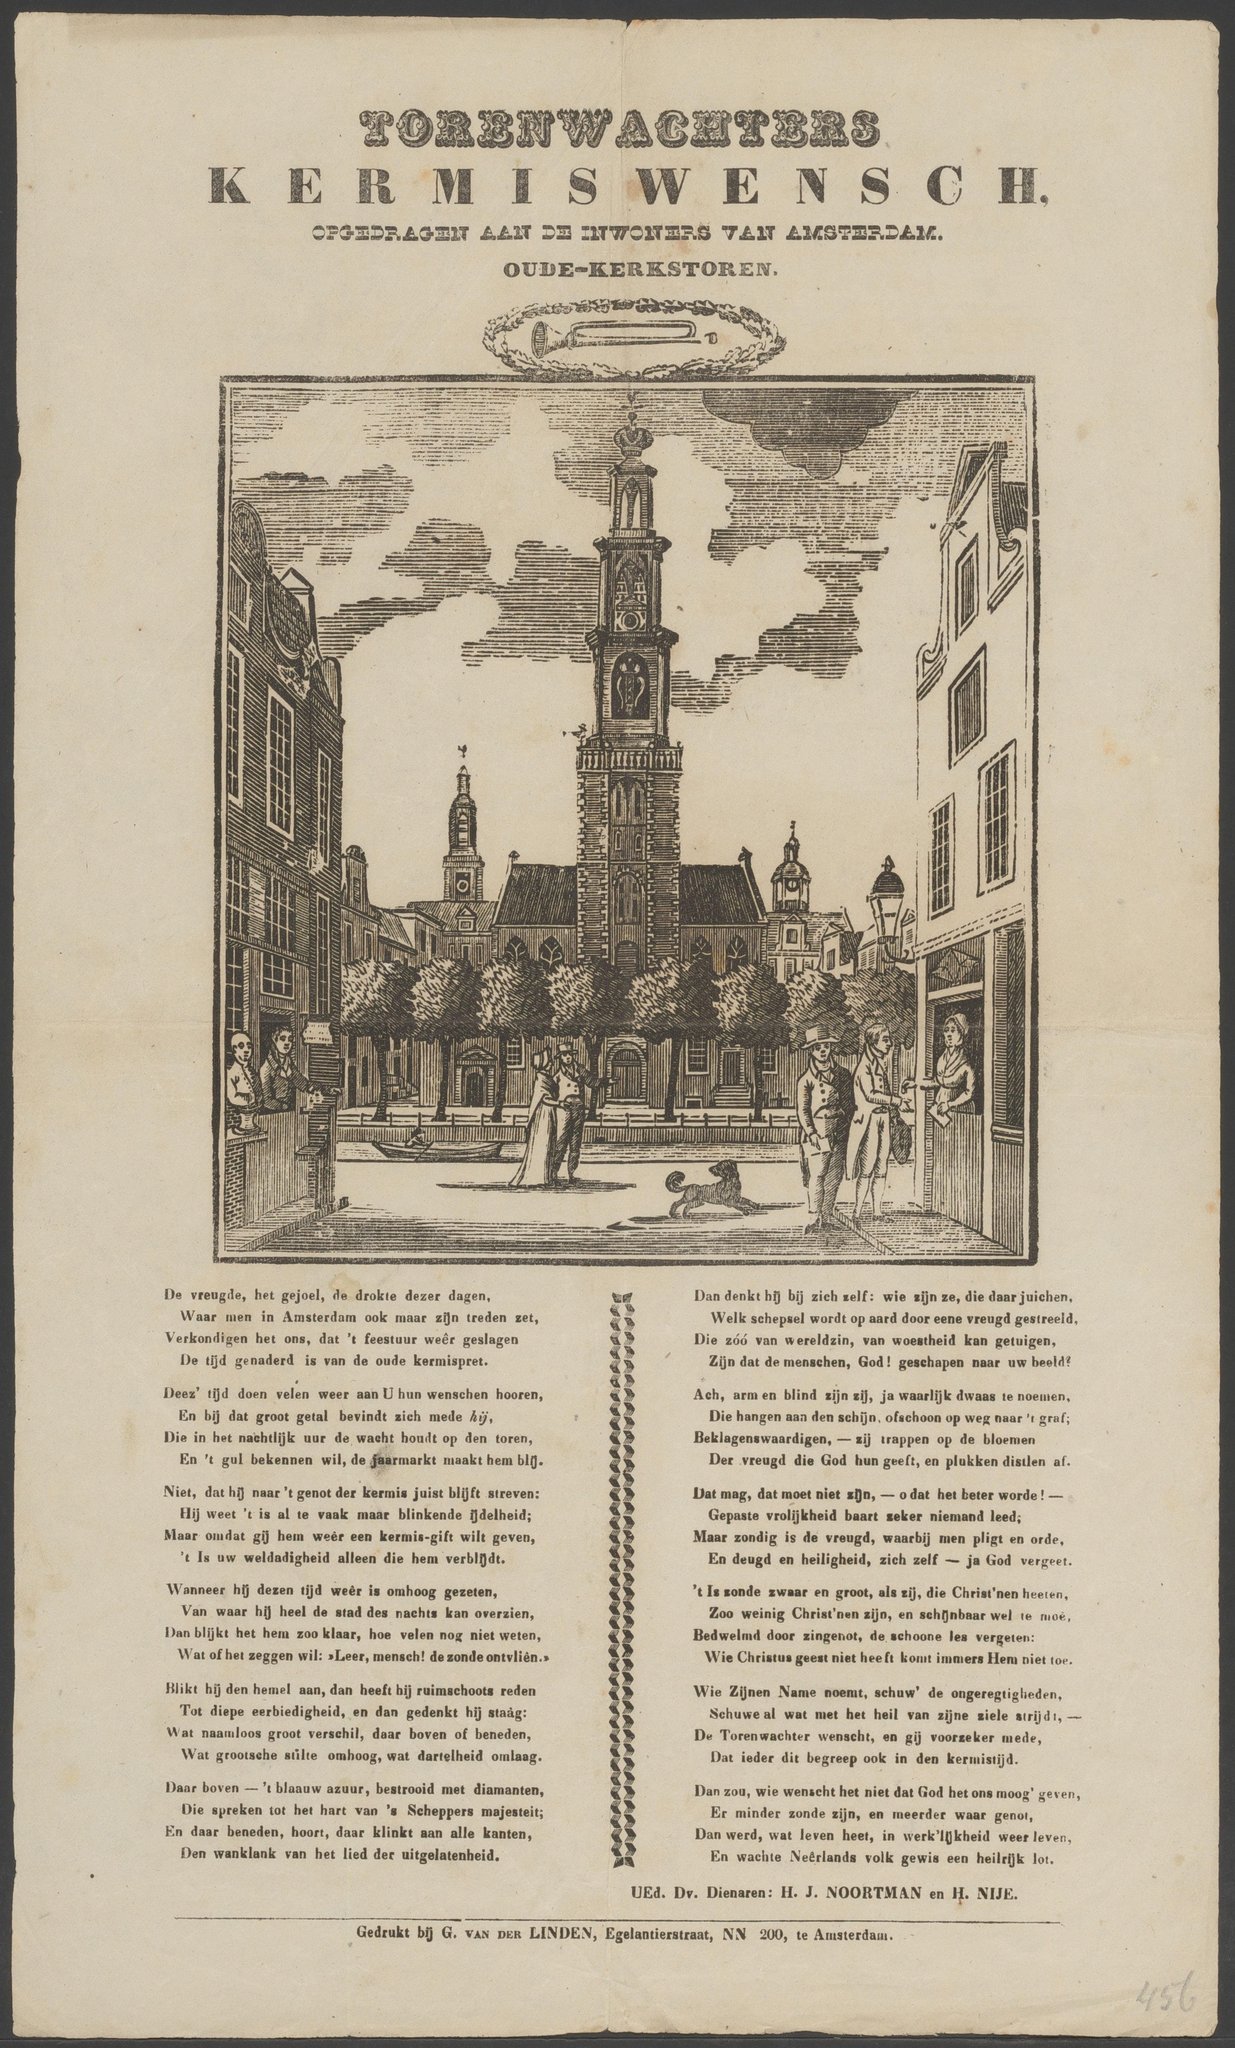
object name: print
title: Nieuwjaarswens van de torenwachters van toren van de Oude Kerk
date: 1860-1875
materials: paper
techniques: letterpress printing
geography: amsterdam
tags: parts of church exterior and annexes: tower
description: Nieuwjaarswens van de torenwachters van de Oude Kerkstoren te Amsterdam. Bovenaan een gezicht op een kerktoren. Daaronder centraal een gedicht in twee kolommen. Aangeboden door de torenwachters: H.J. Noortman en H. Nije. Onderwerpsrubrieken binnen de Atlas Zeden en Gewoonten: Zeden en gewoonten in engeren zin, Volksleven, Volksbladen, Nieuwjaars- en Kerstwenschen, Amsterdam.